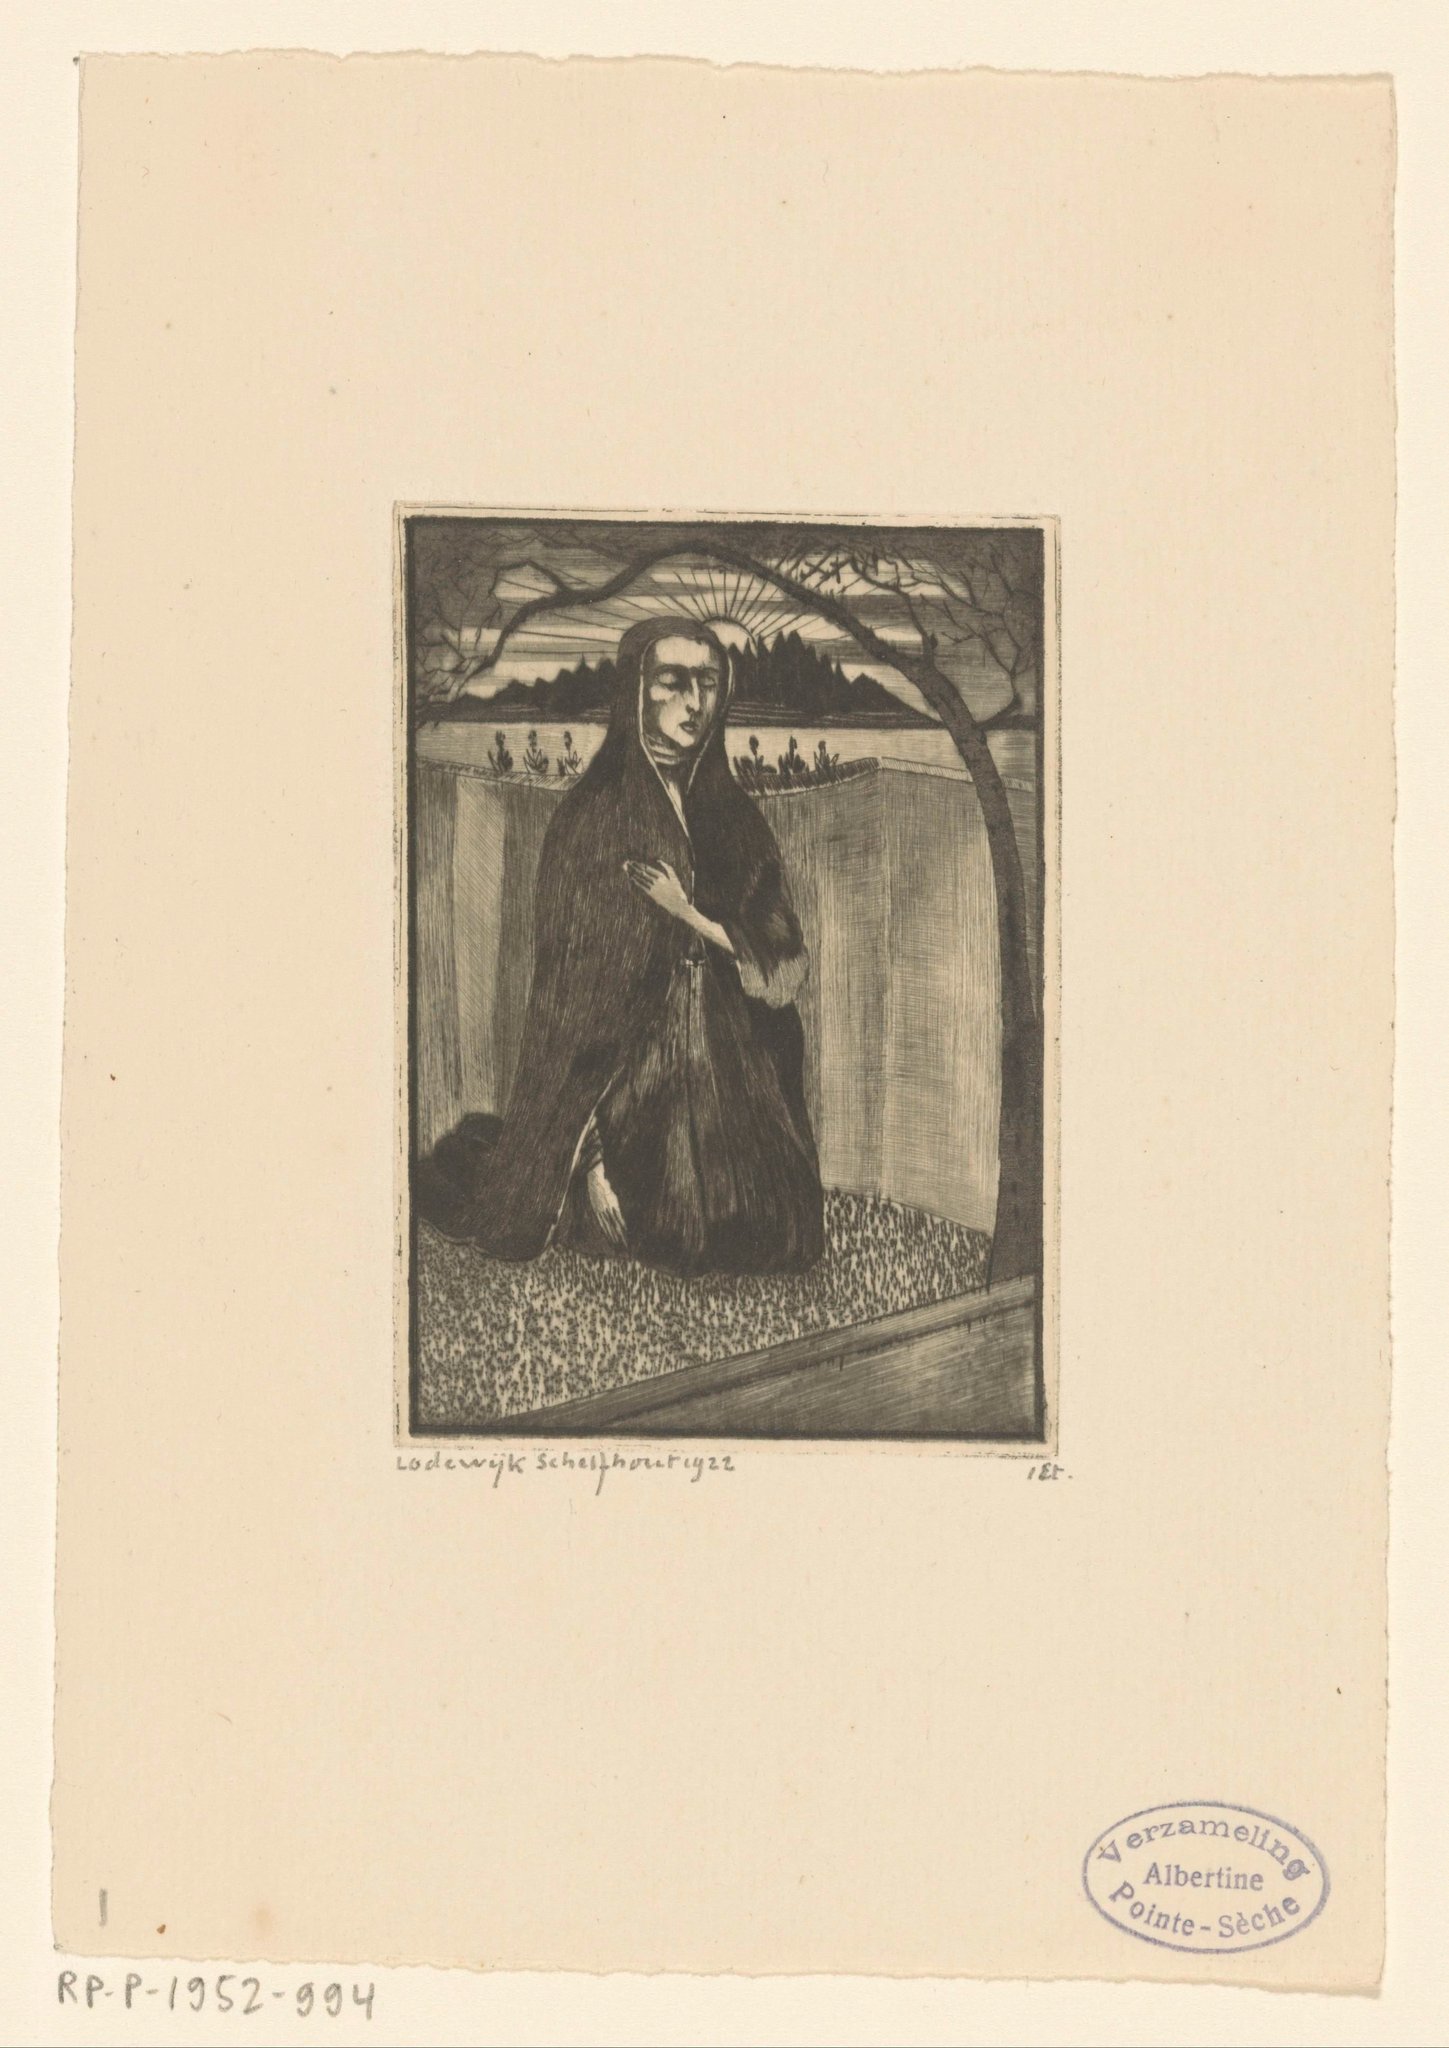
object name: print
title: Femme au tombeau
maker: lodewijk schelfhout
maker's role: draughtsman, print maker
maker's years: 1881-1943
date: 1922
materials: paper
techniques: drypoint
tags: kneeling figure - aa - female human figure, grave, tomb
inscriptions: collector's mark: Lugt 2228, collector's mark: Lugt 2760, collector's mark: Lugt 5i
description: Een gesluierde vrouw, knielend bij een tombe. Op de achtergrond de zon boven bergen.